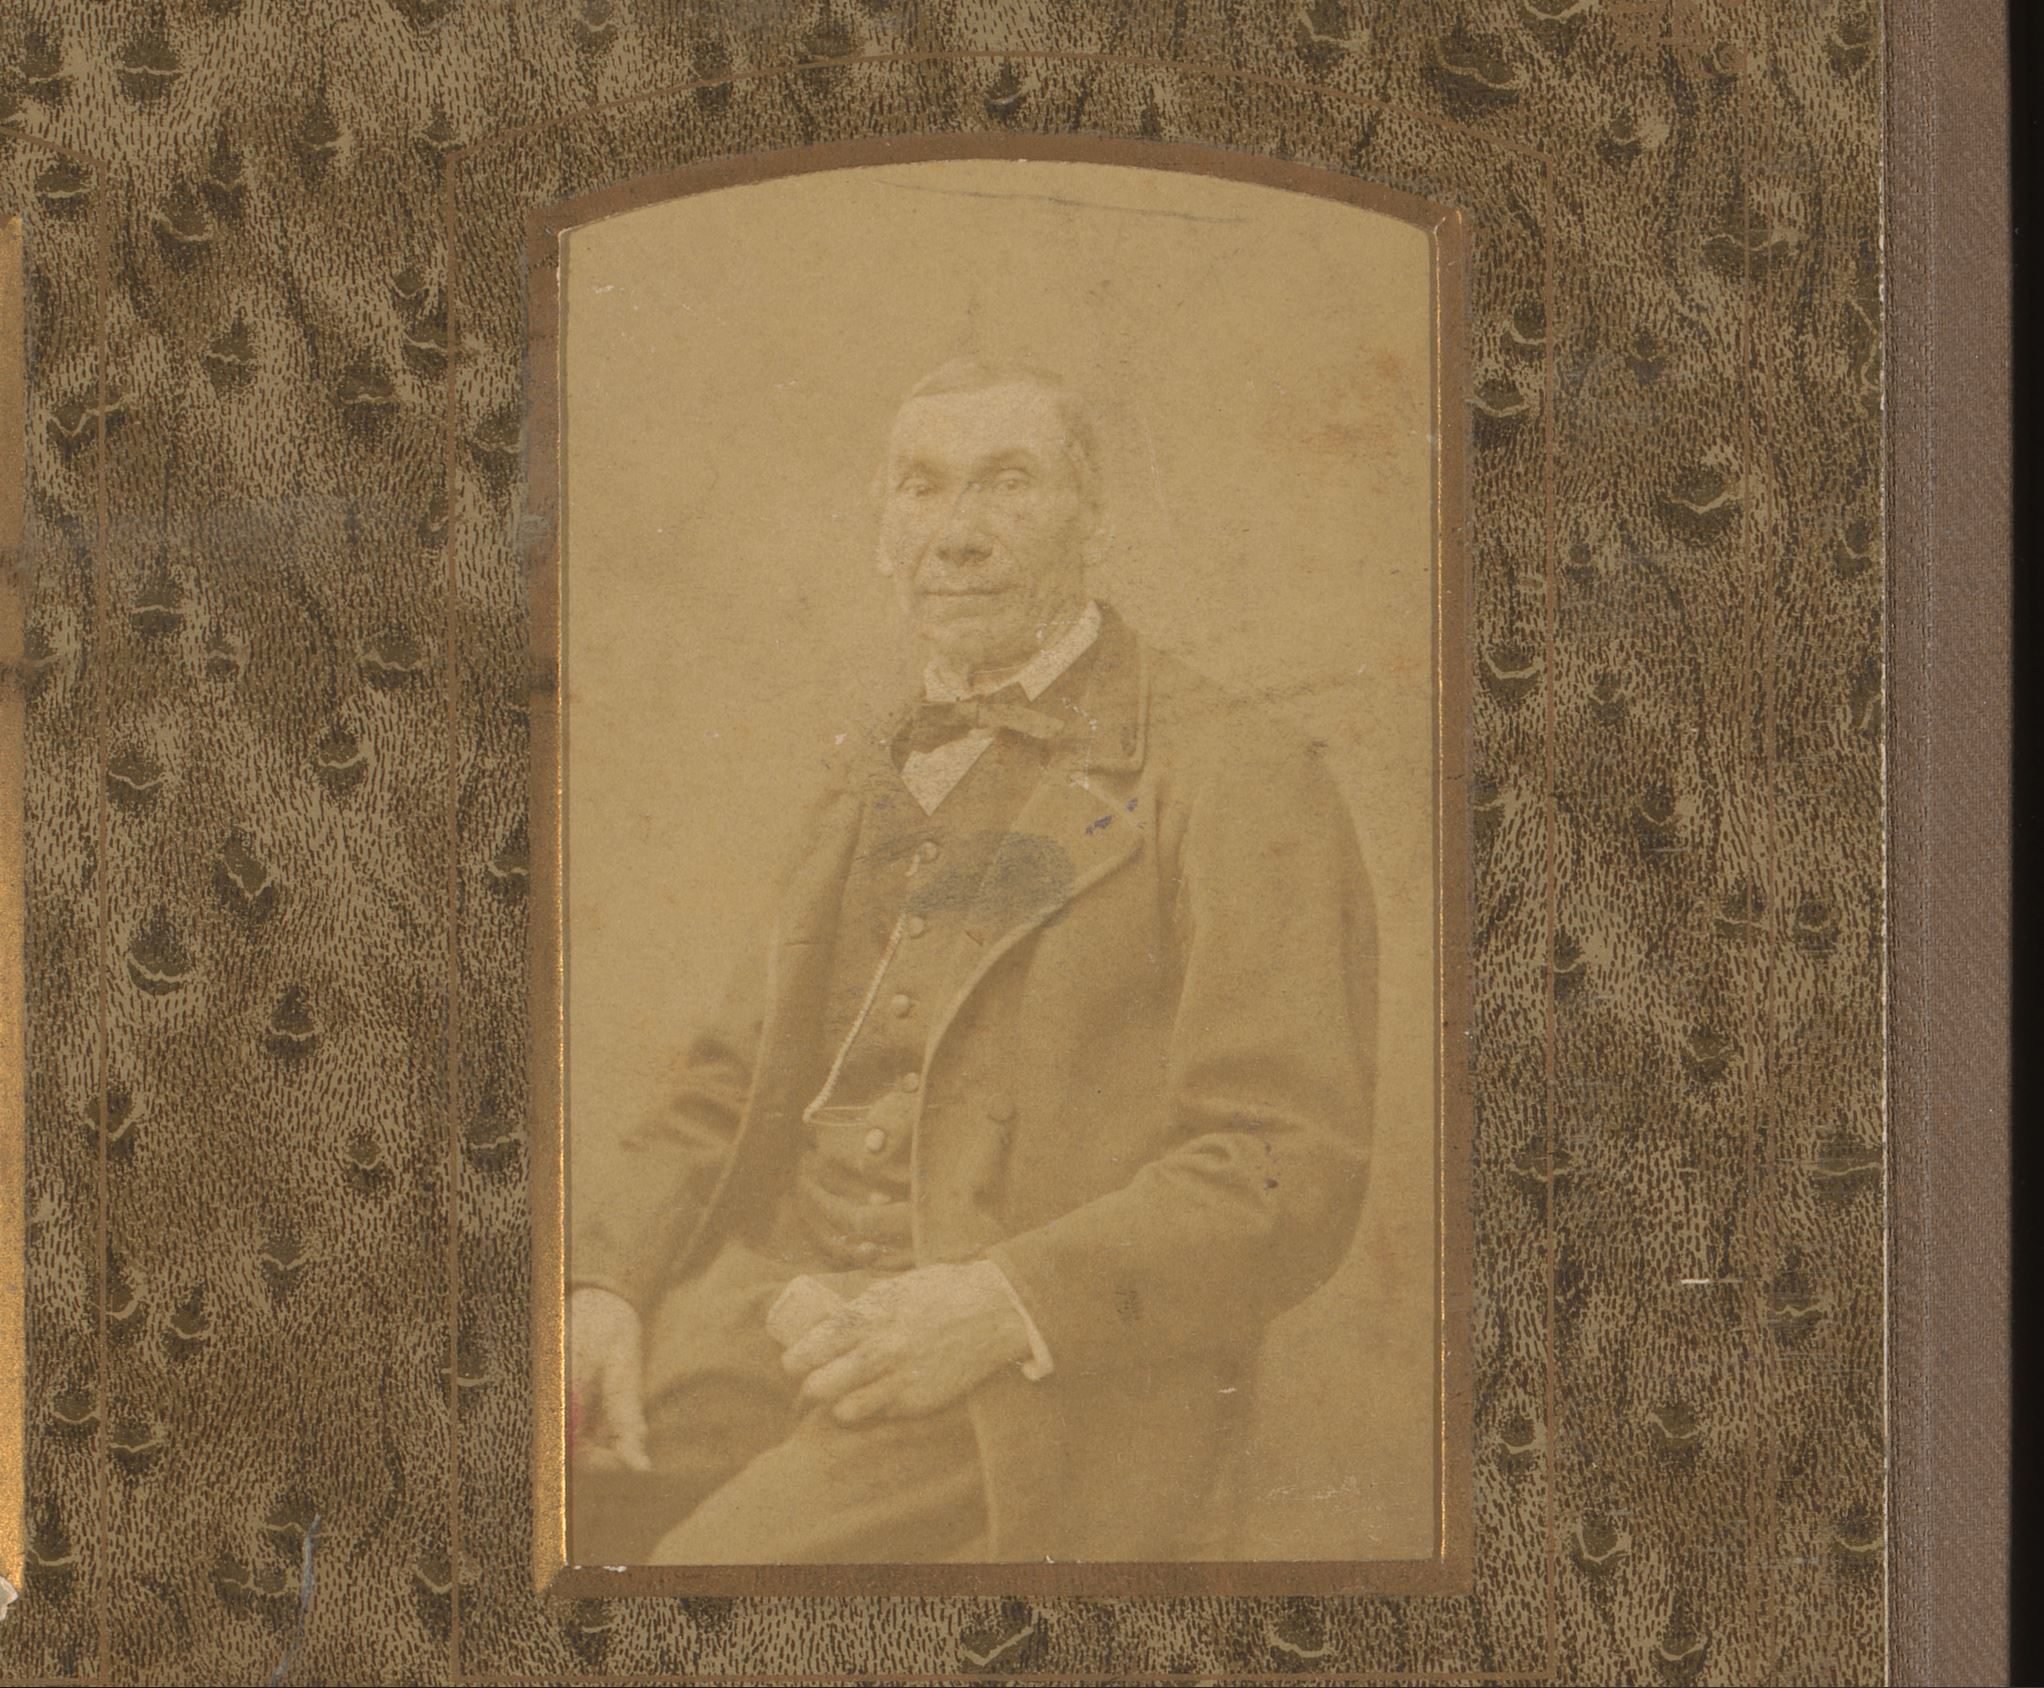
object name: album leaf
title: Portret van een man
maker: jouve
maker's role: fotograaf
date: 1880-1900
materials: cardboard, photographic support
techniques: albumen print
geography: grenoble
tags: historical persons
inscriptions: inscription: ‘JOUVE/ Peintre Photographe/ 52, Quai Perrière, 52/ GRENOBLE./ Tous les Clichés sont conservés.’